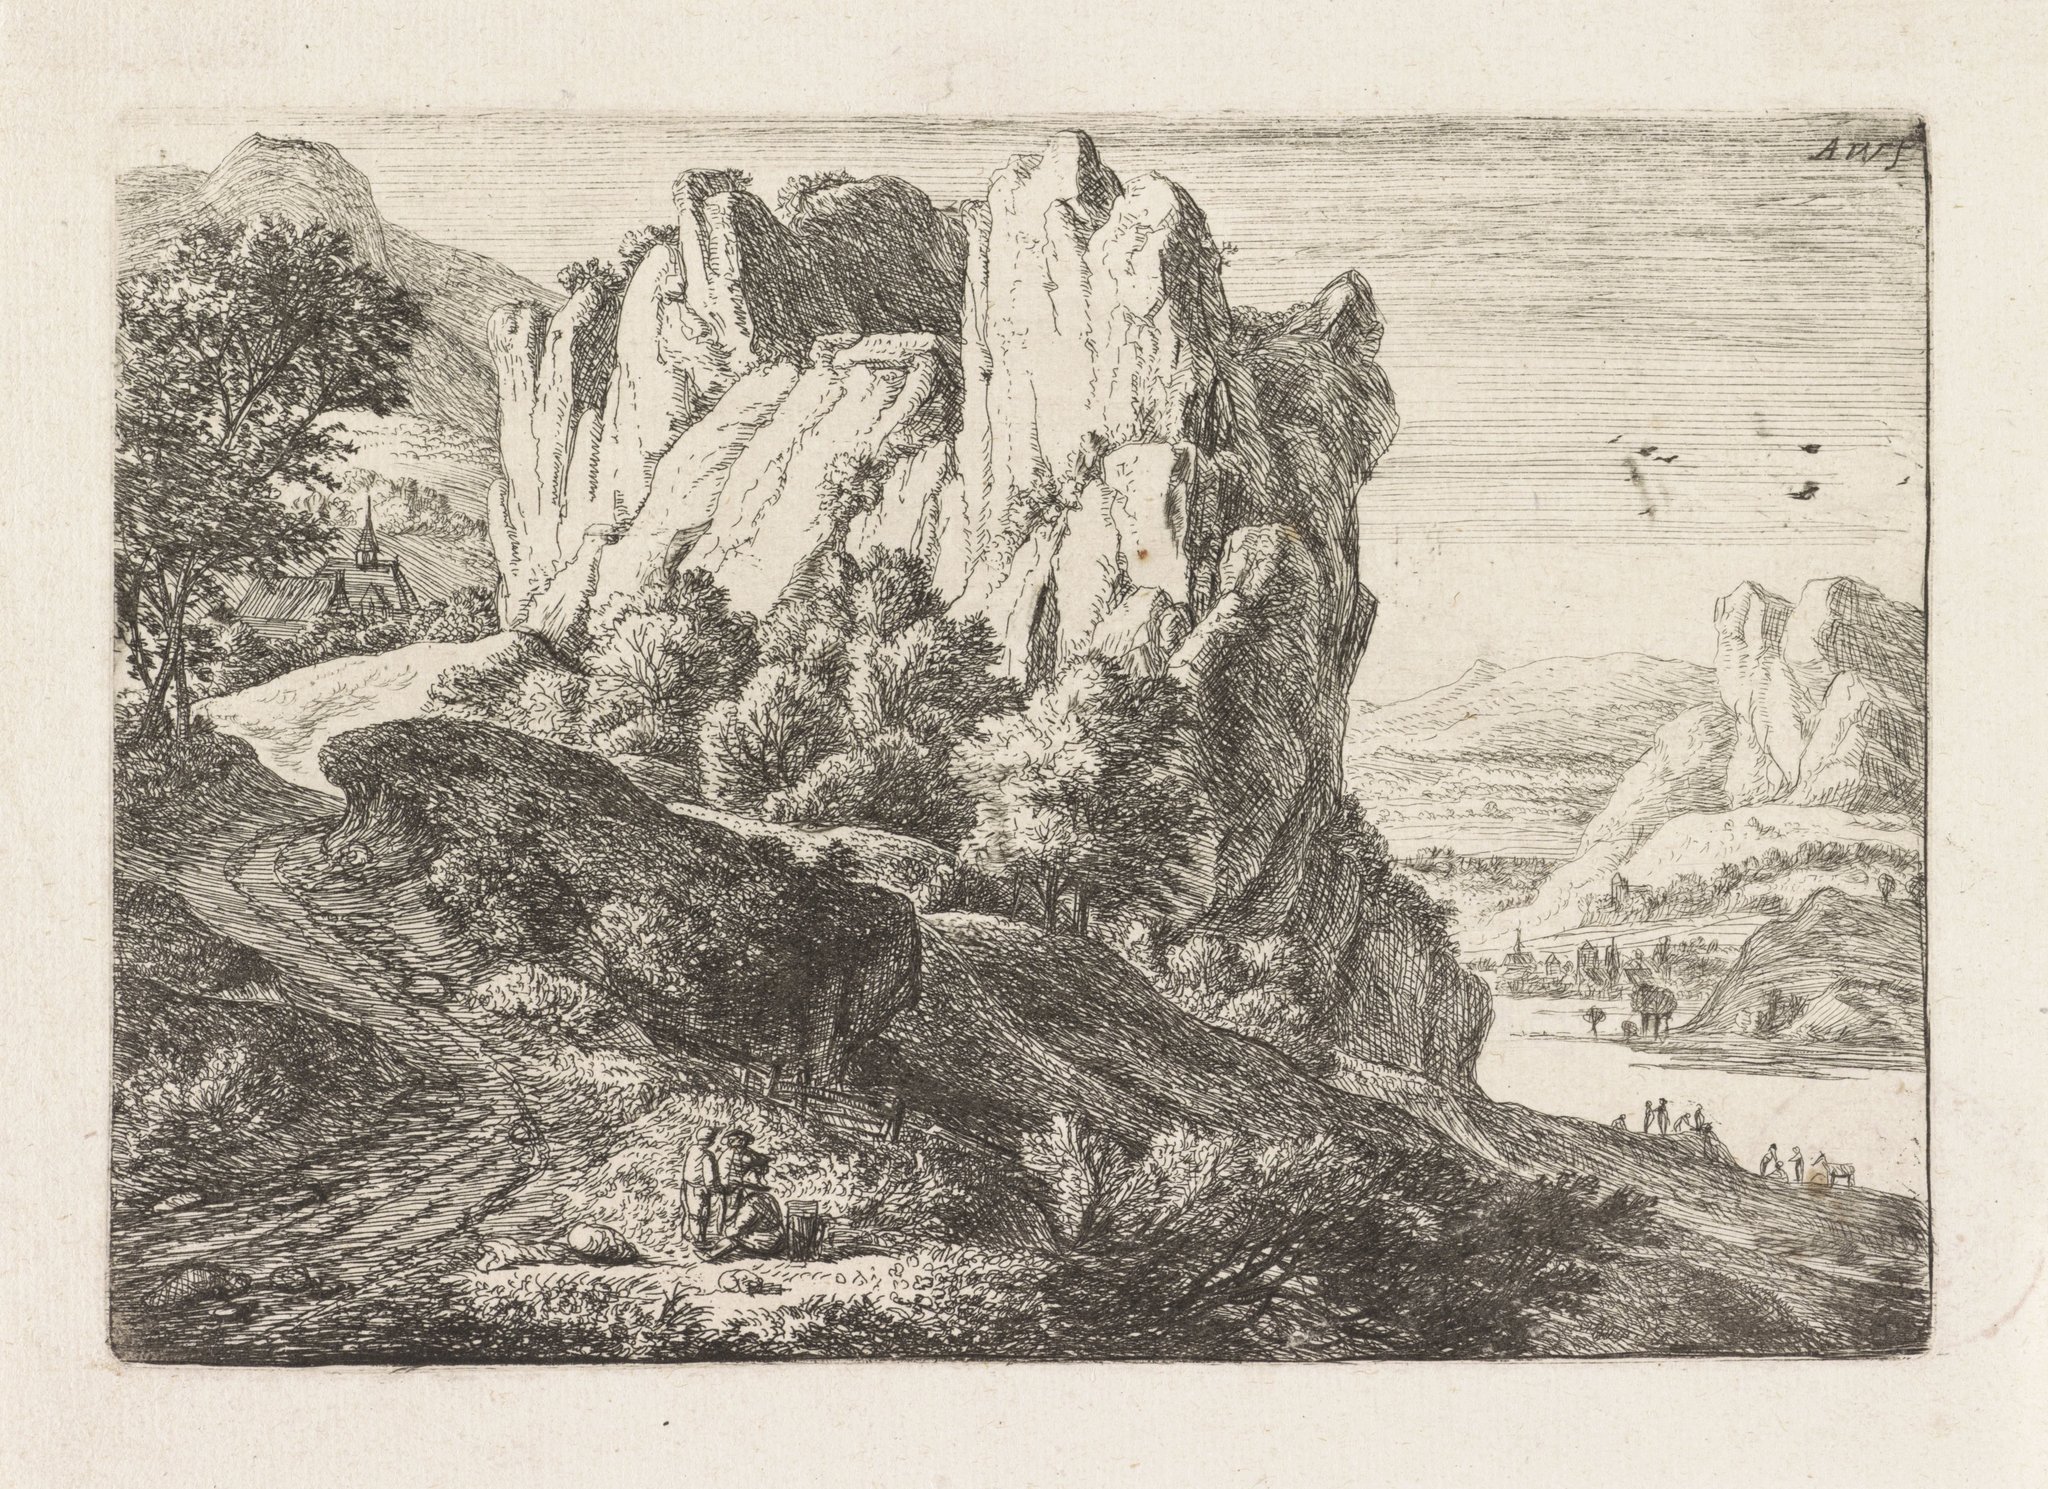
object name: print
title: Landschap met een steil pad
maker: anthonie waterloo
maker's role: draughtsman, painter, print maker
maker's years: 1609-1690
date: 1630-1663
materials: paper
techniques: etching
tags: river, village, road, path, rock-formations, church (exterior) - qq - small church, chapel, landscapes (+ landscape with figures, staffage)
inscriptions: collector's mark: Lugt 240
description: Links leidt een steil pad langs een grote rotspartij naar een kleine kerk of kapel. Langs het pad zijn drie figuren weergegeven. Rechts staan nog enkele figuren aan de oever van een rivier. In de verte ligt een dorp.